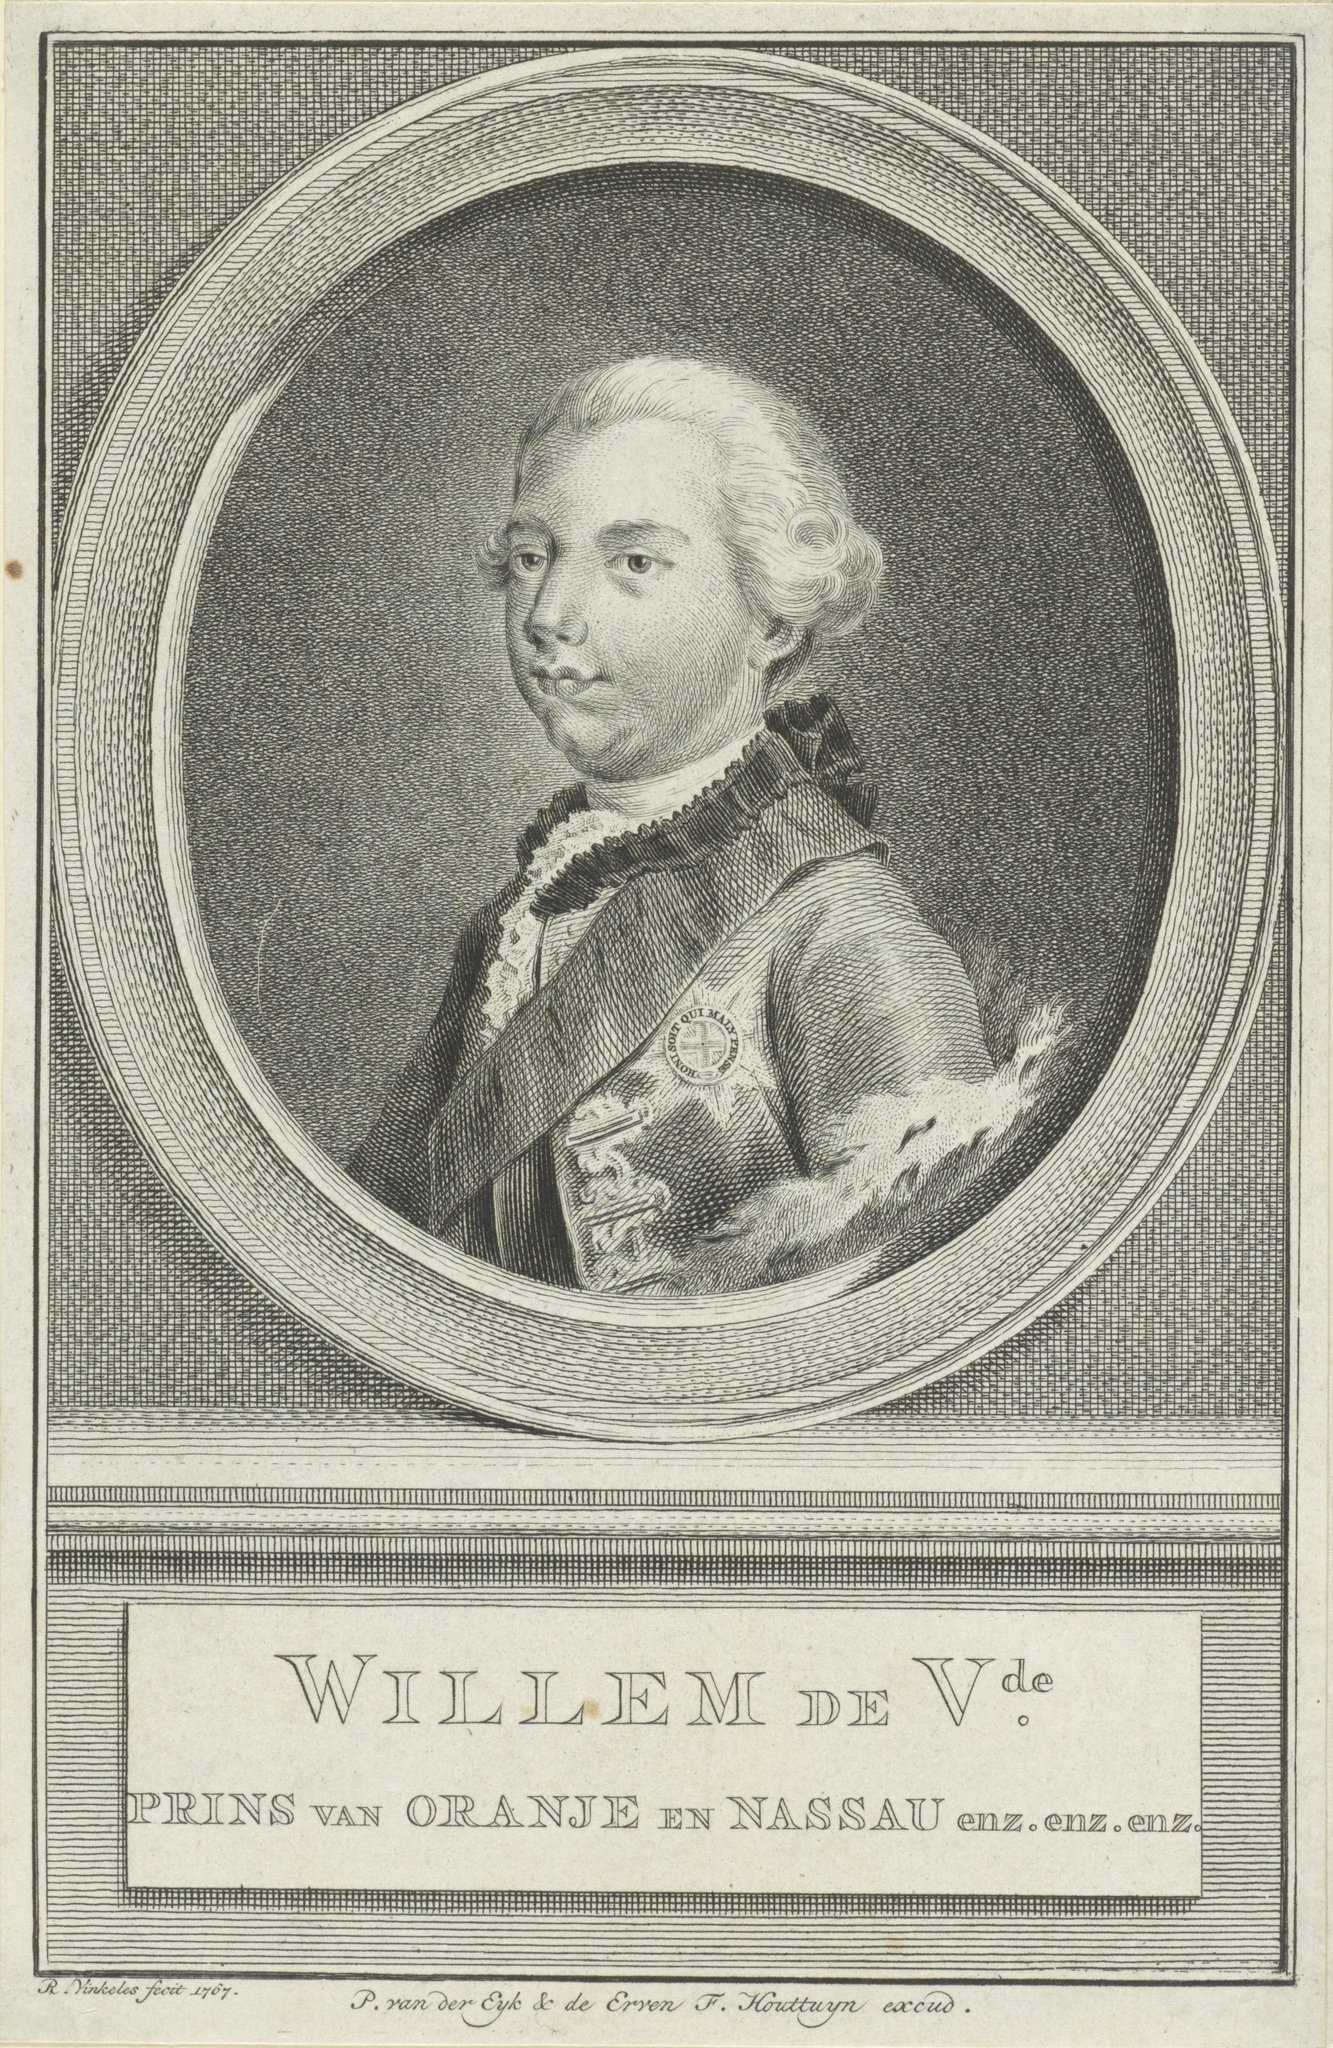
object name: print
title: Portret van Willem V, prins van Oranje-Nassau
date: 1767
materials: paper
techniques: engraving, etching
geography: amsterdam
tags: the hague, william v (prince of orange), knighthood order (garter) - insignia of a knighthood order, e.g.: badge, chain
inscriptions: date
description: De hier vermelde titel verwijst naar de hoogst verkregen titel van de geportretteerde, niet per se naar de titel die de geportretteerde op deze voorstelling draagt.